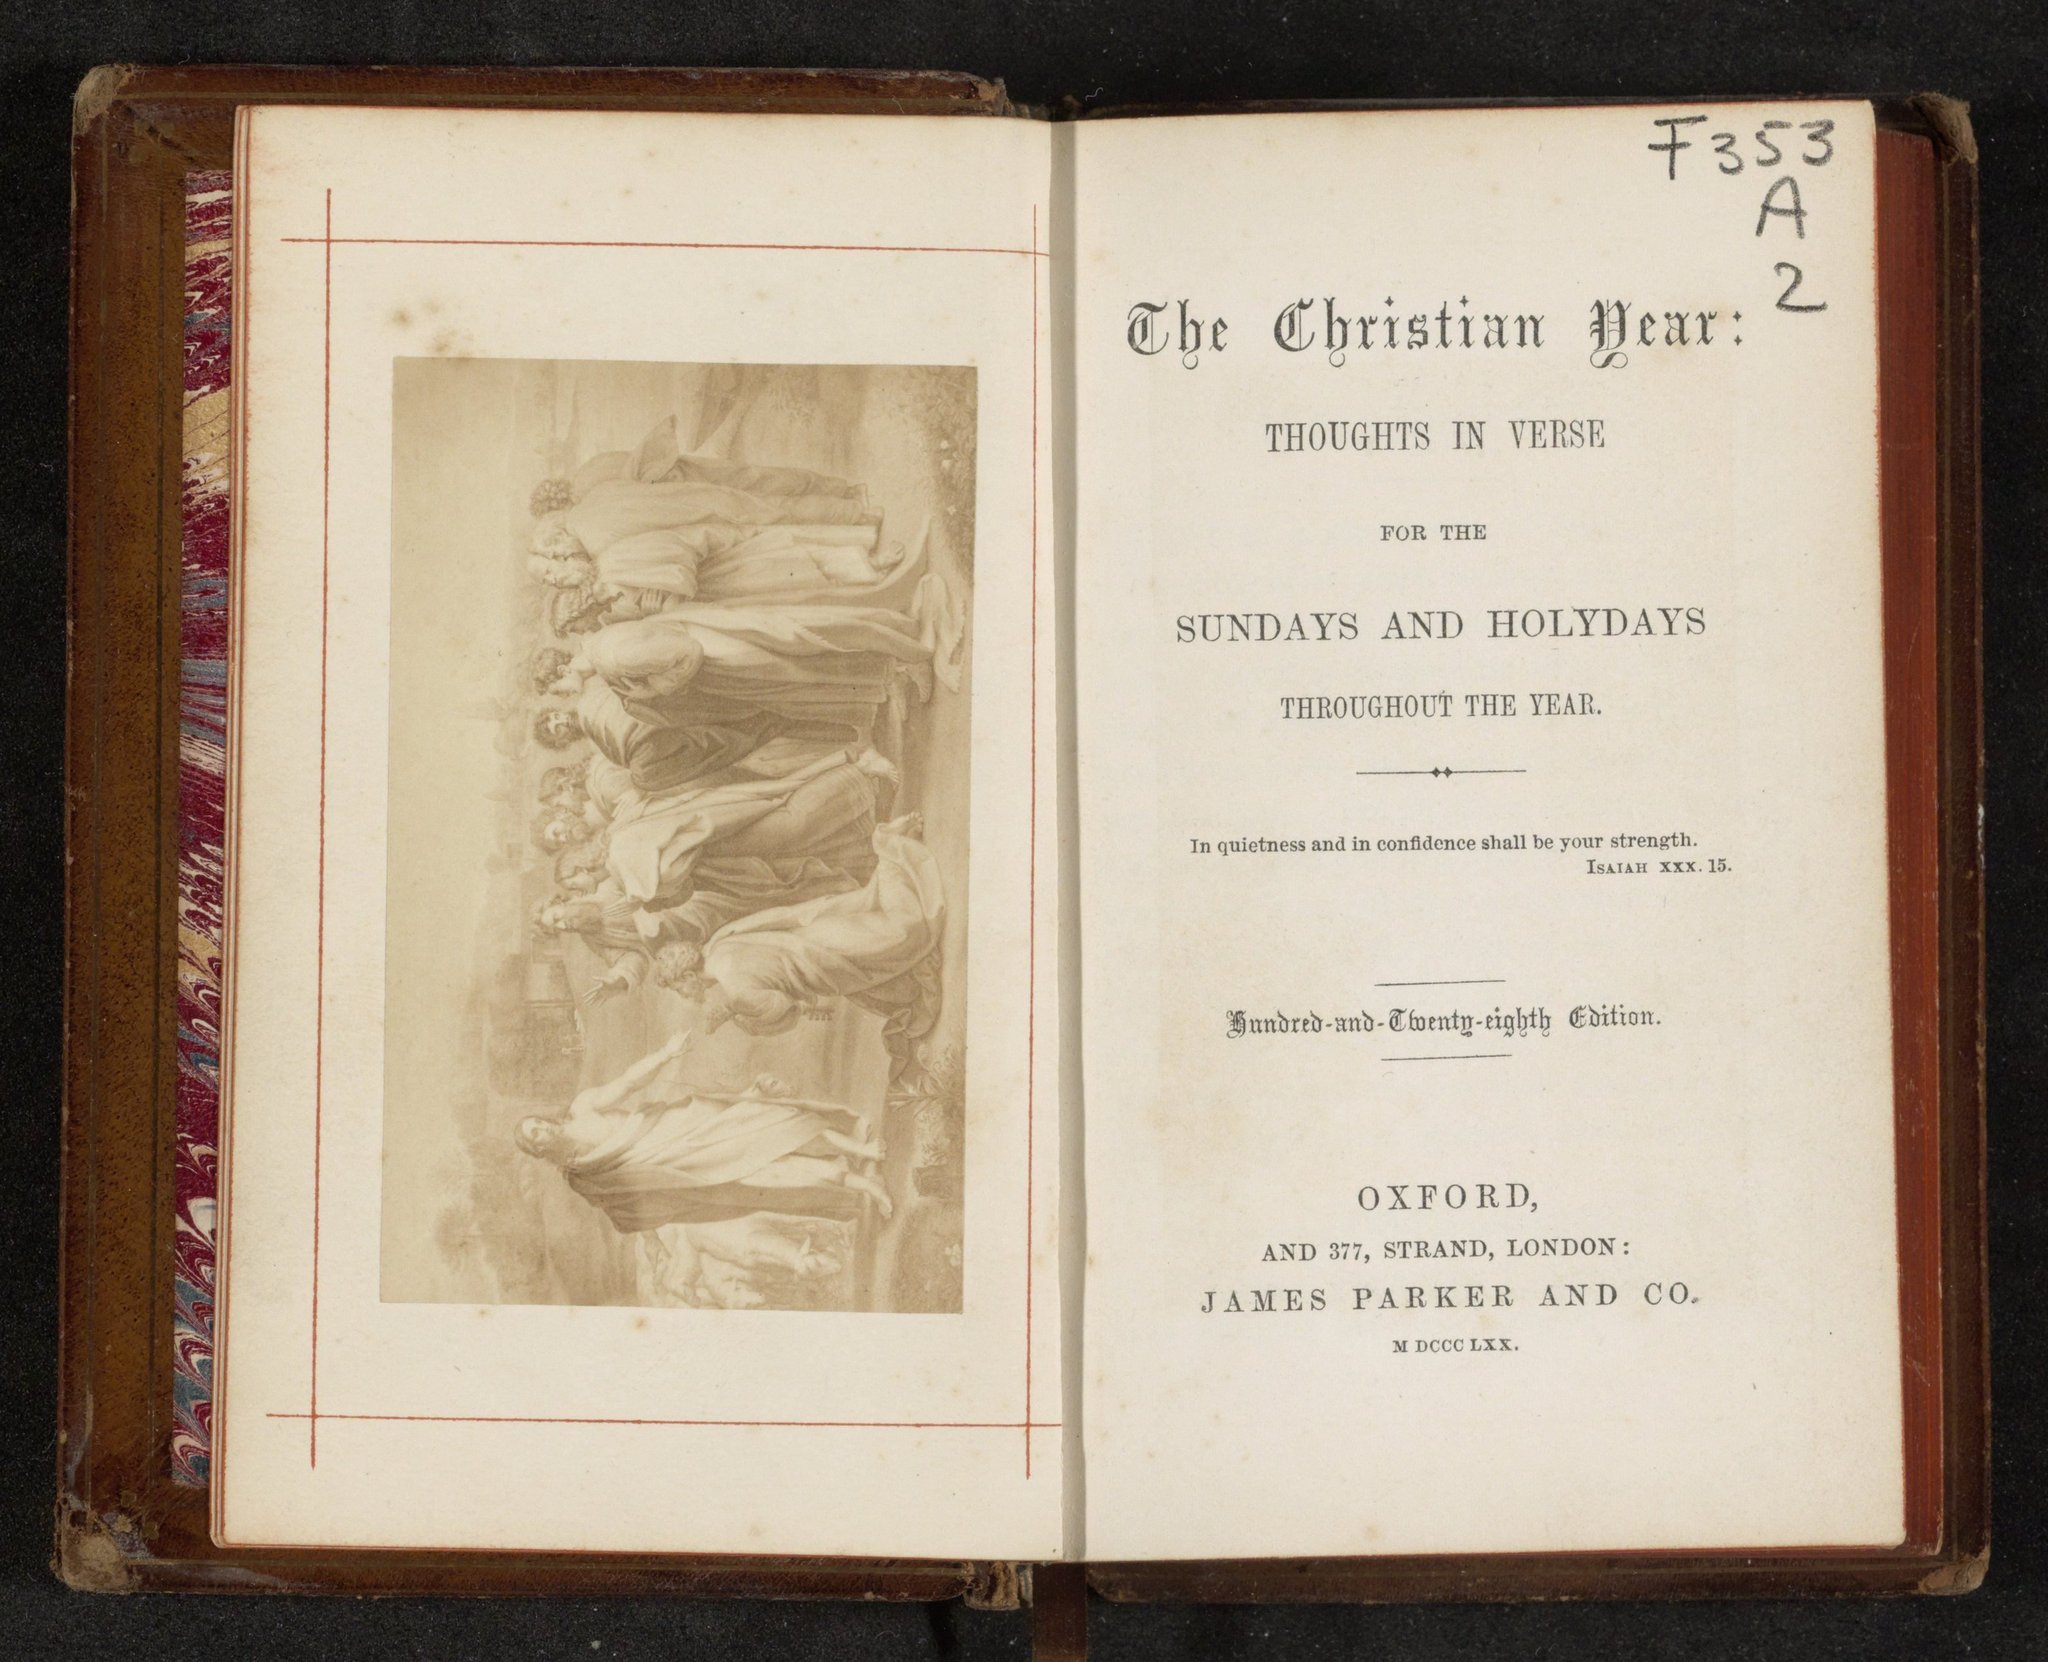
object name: book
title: The Christian year. Thoughts in verse for the sundays and holydays throughout the year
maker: john keble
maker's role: dichter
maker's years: 1792-1866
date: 1870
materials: cardboard, linen, paper, photographic support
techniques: albumen print, printing, marbled paper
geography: oxford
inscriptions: inscription: ‘Betty. with love from Auntie March 1934.’